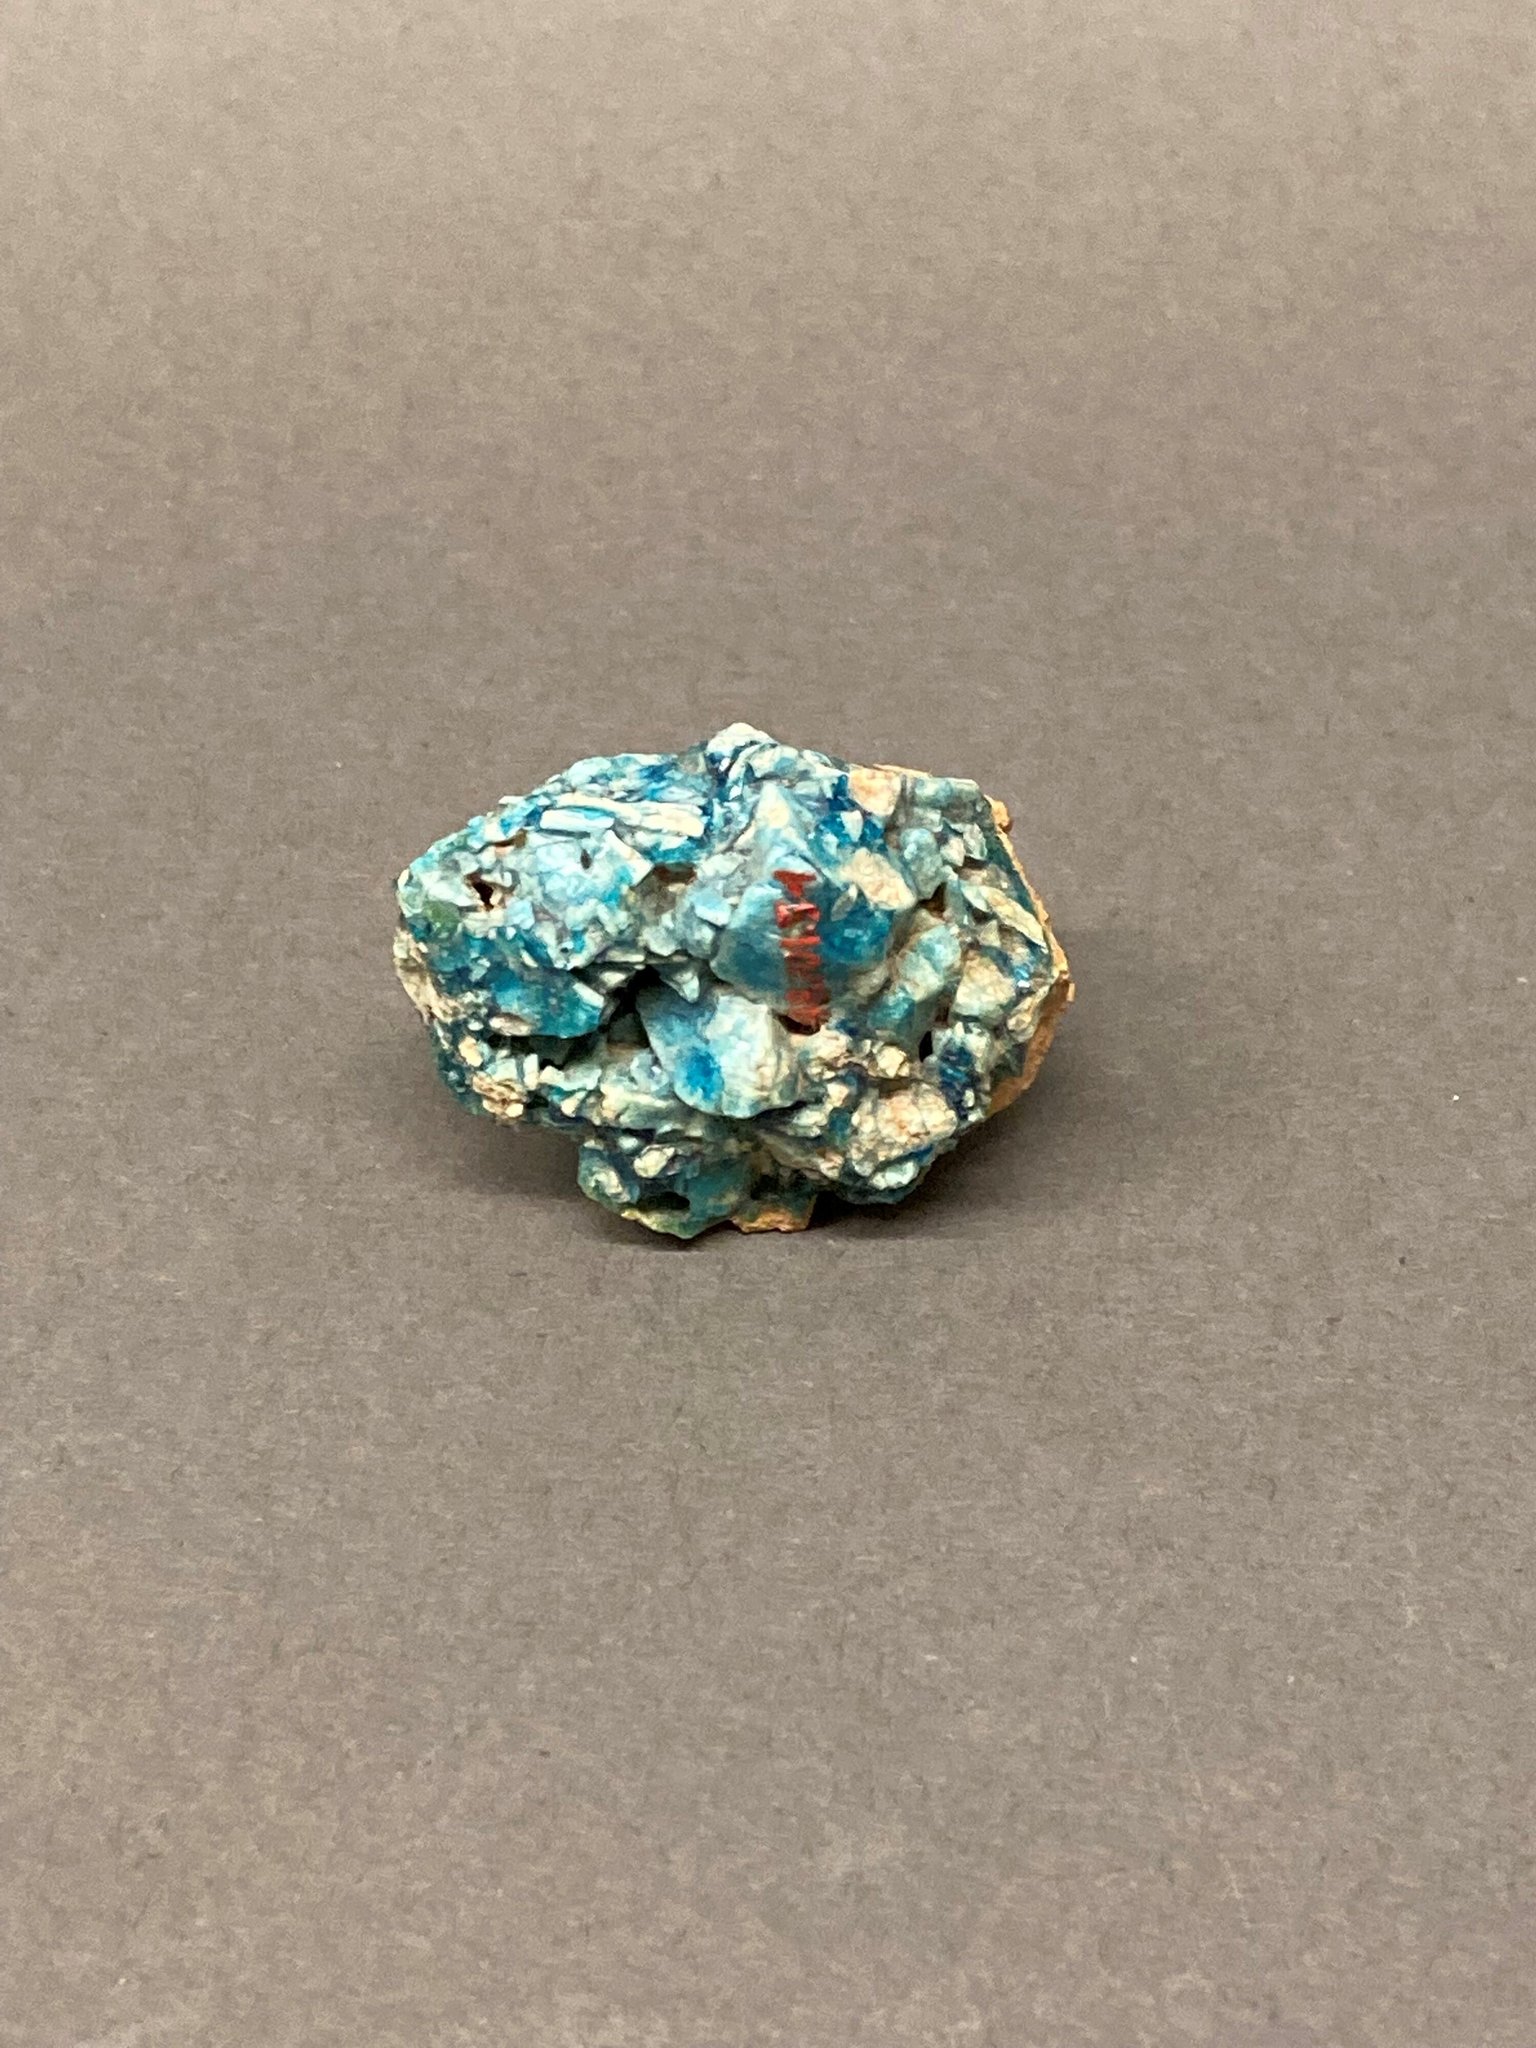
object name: fragment of a waster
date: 1001-1200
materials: earthenware, stonepaste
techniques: glazing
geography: iran